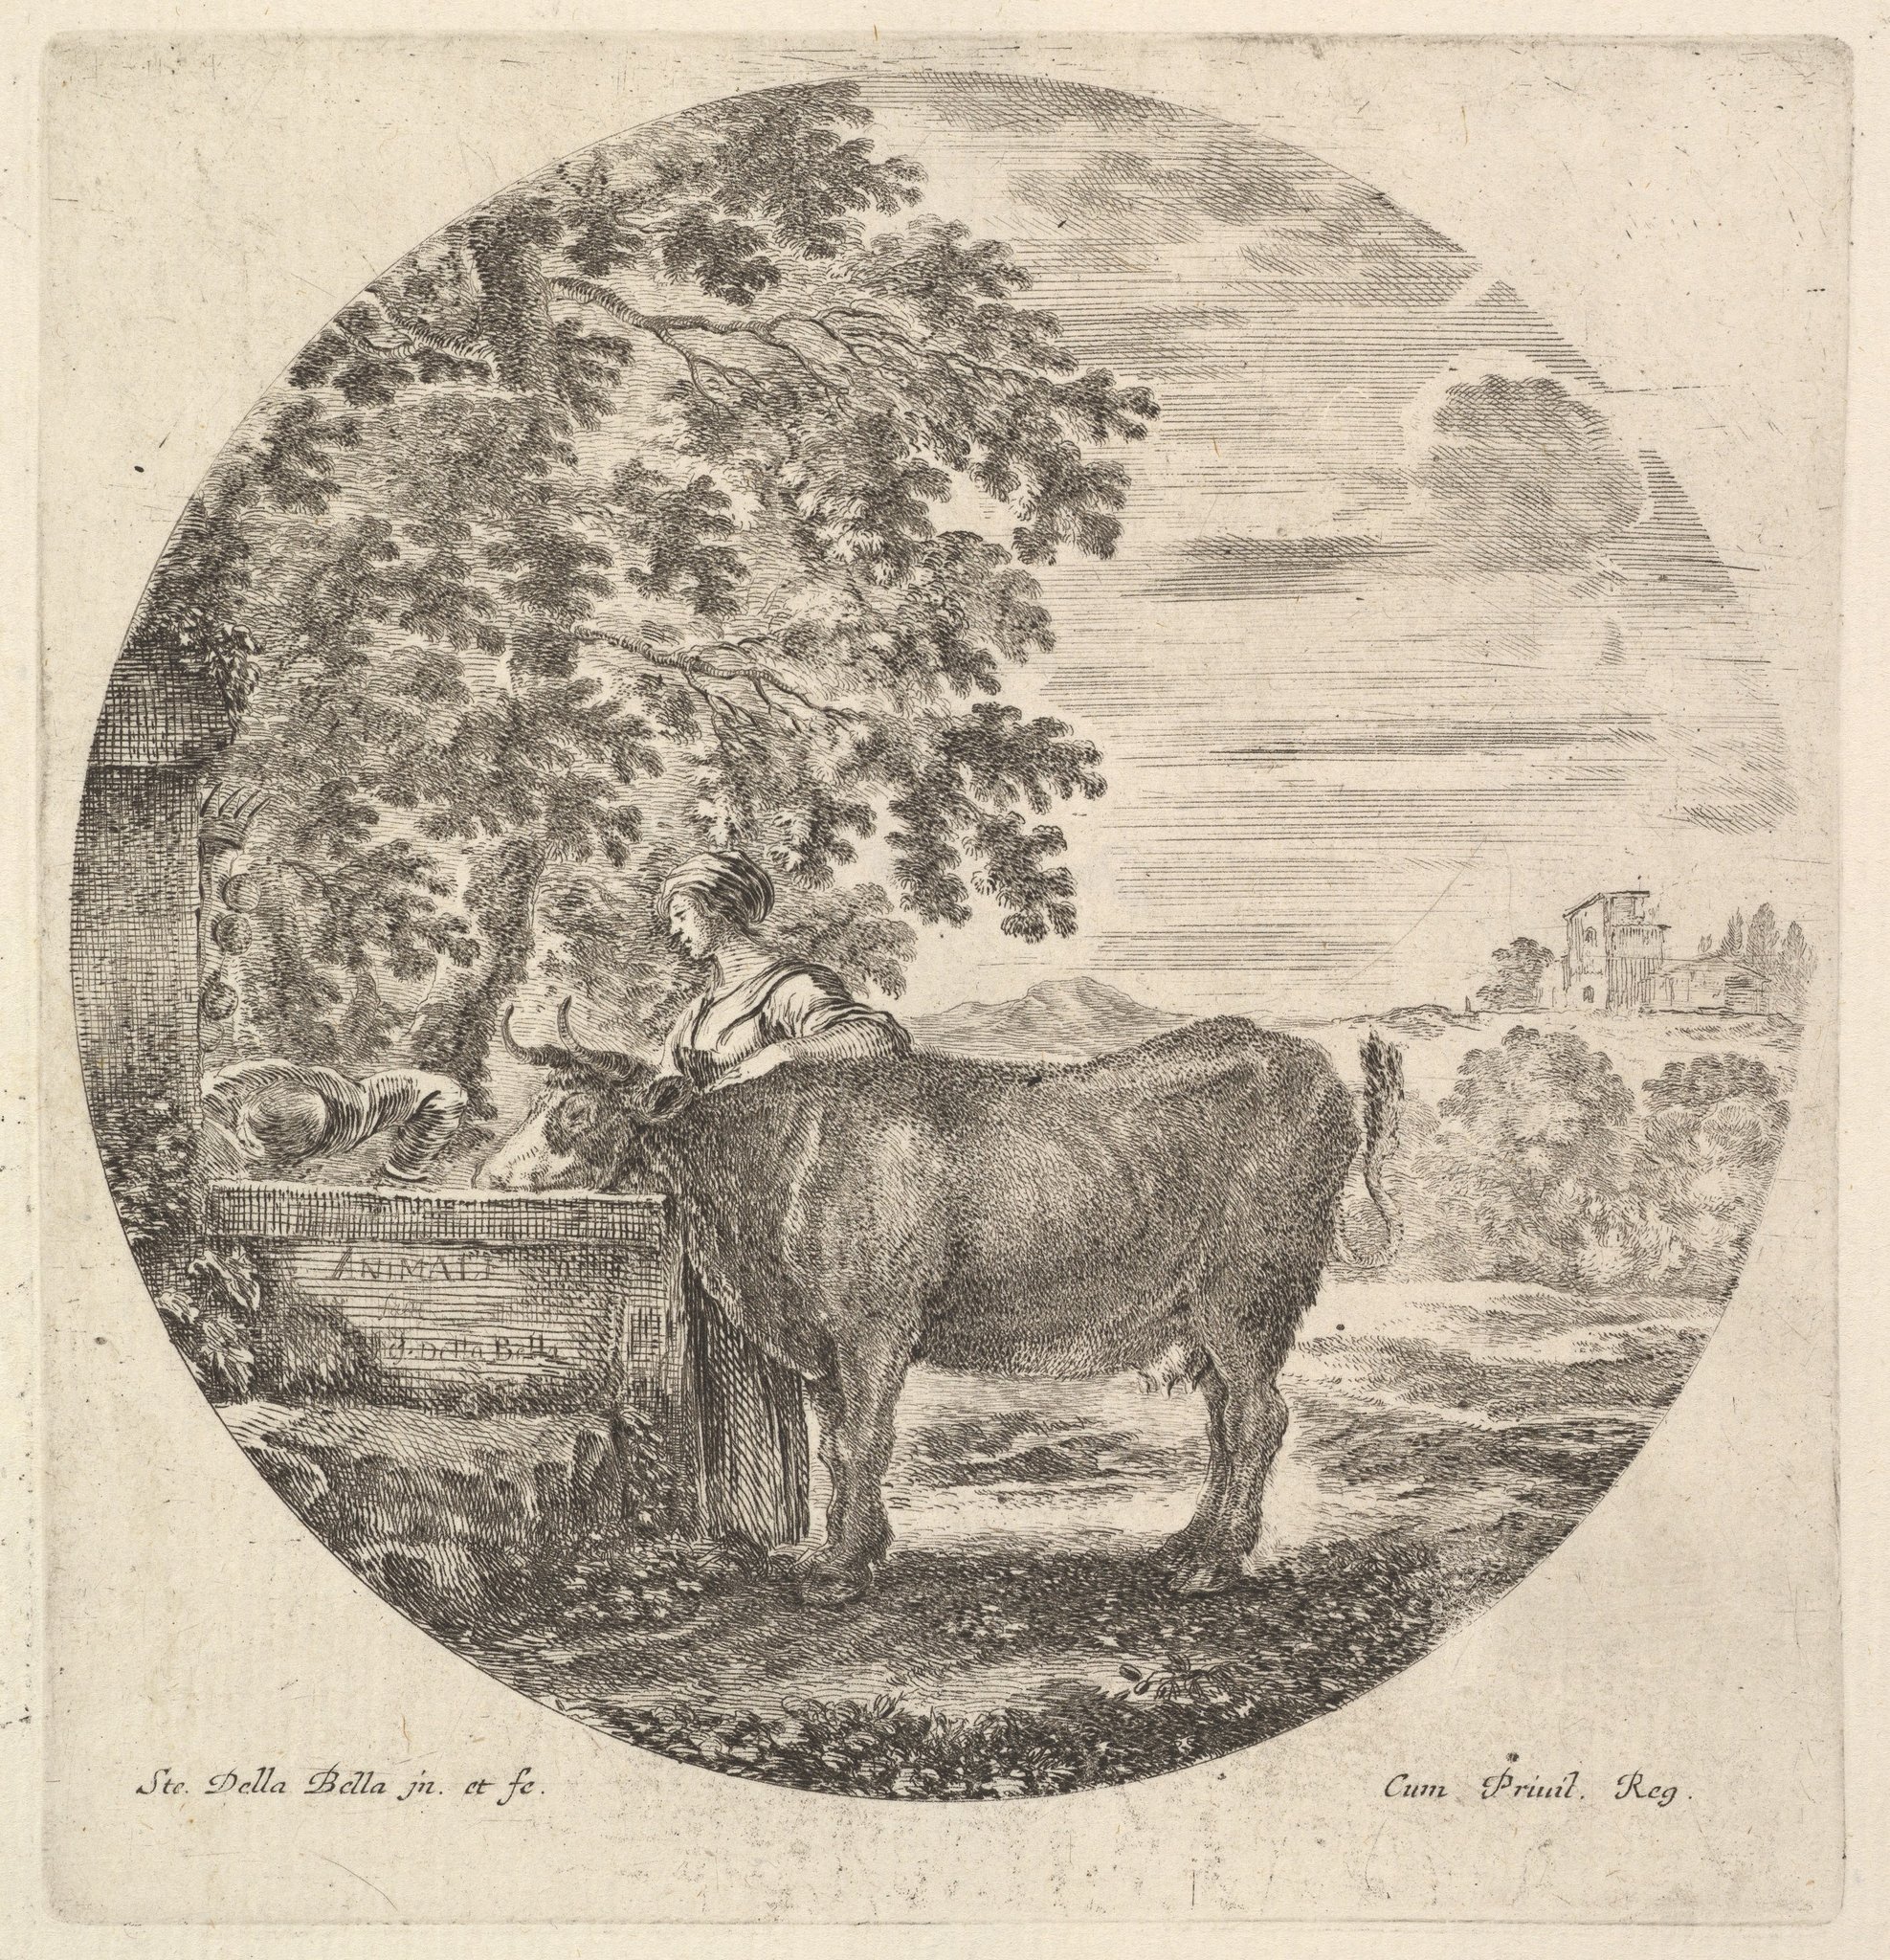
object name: print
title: A cow in center drinking from a fountain adorned with the Medici coat of arms at left, accompanied by a shepherd standing behind, from "Six Animal Subjects" (Six Sujets d'Animaux)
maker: stefano della bella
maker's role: artist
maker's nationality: italian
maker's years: 1610-1664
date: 1643-1648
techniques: etching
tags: human figures,fountains,cows,drinking,shepherds